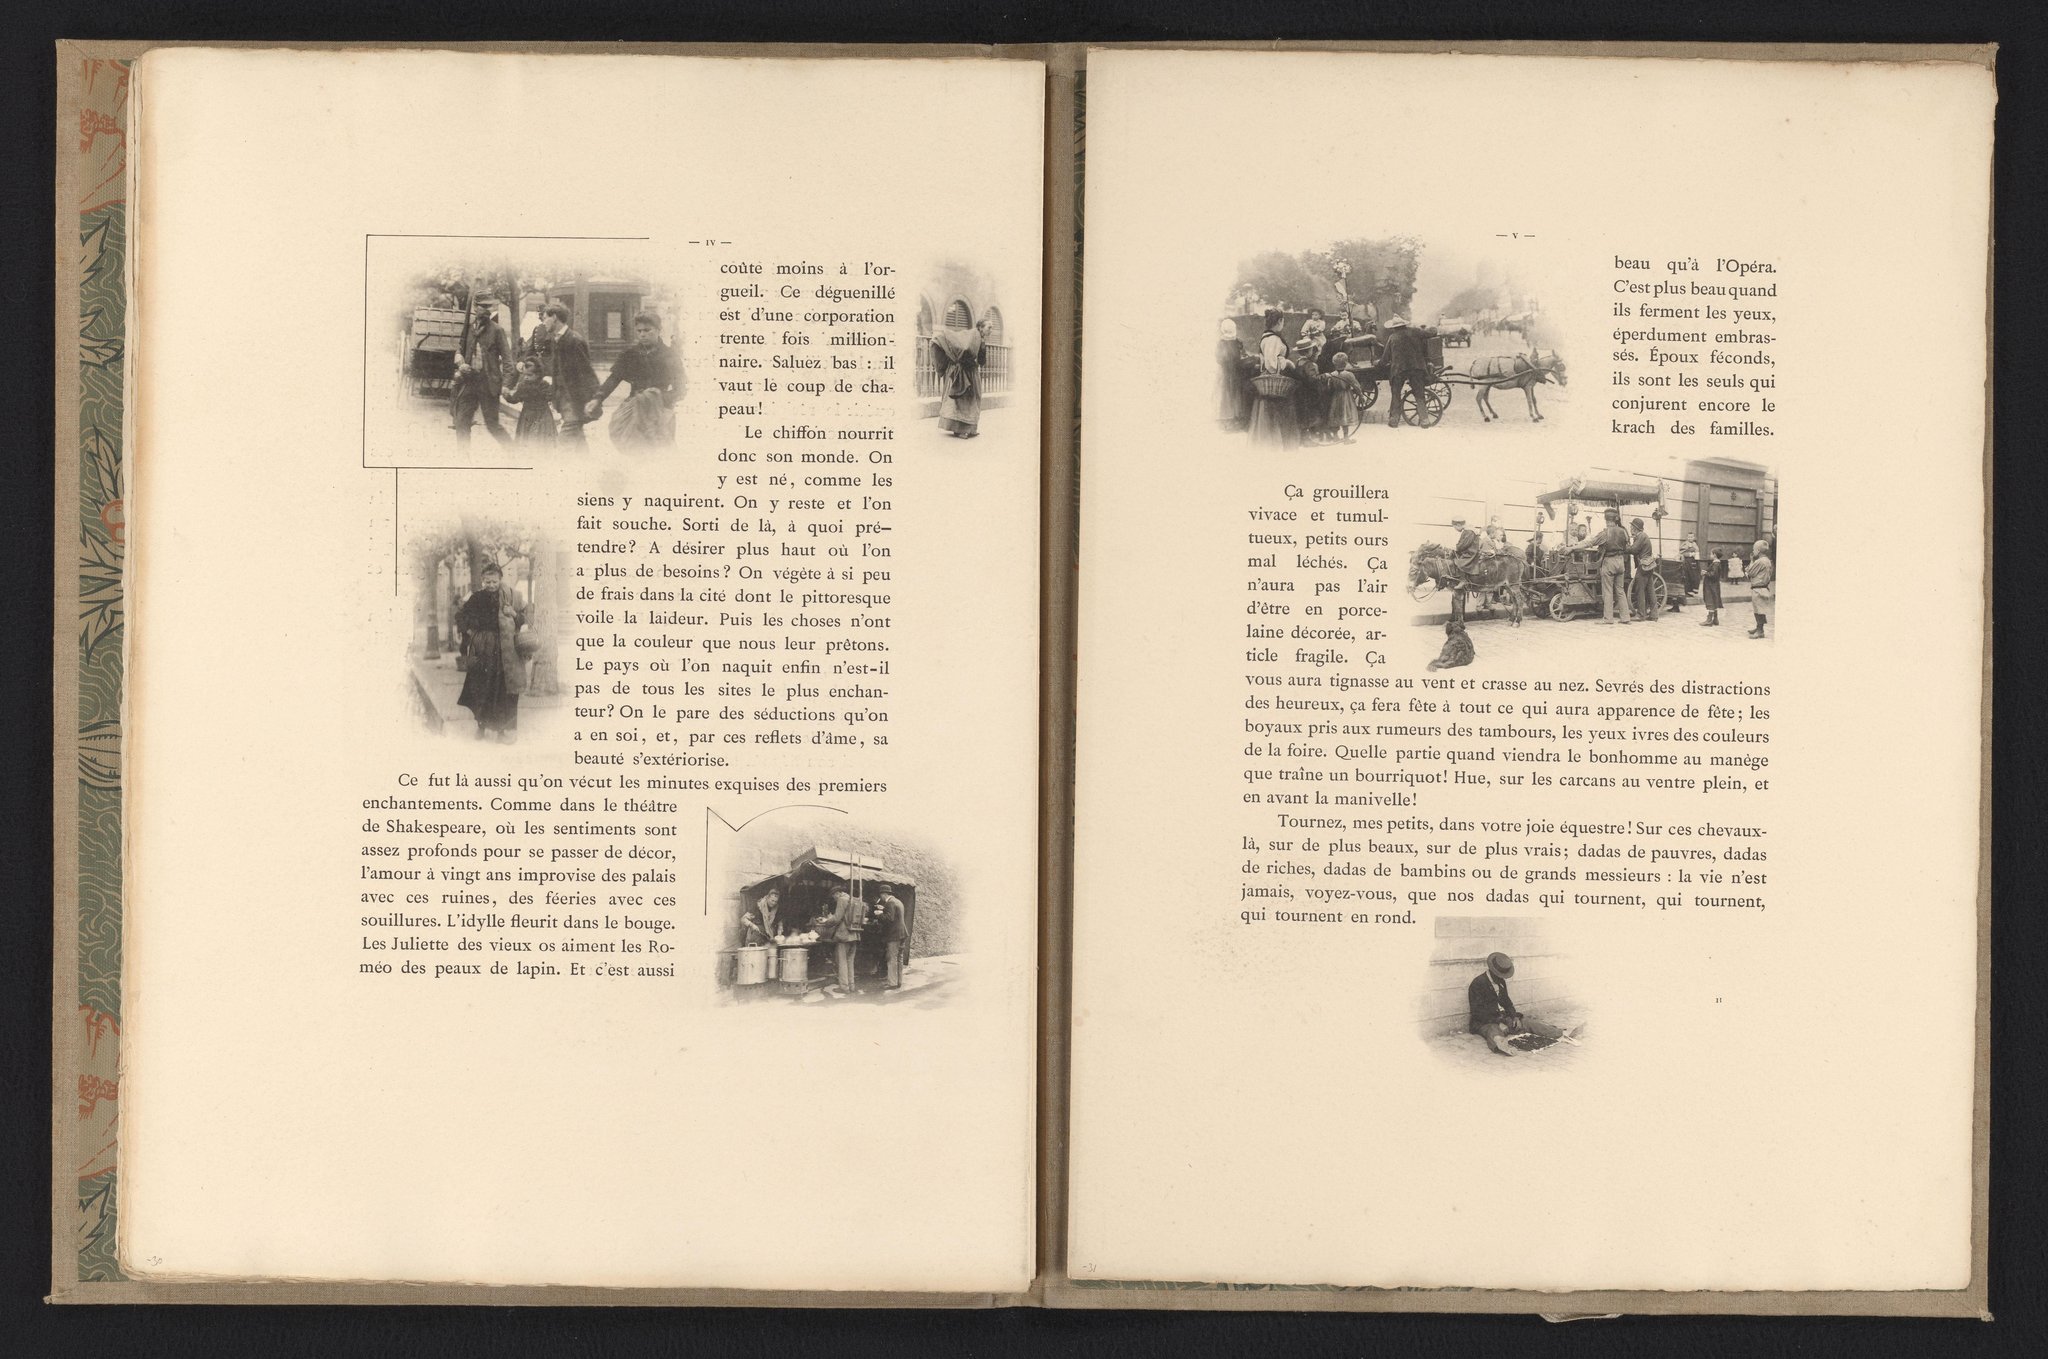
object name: album leaf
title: Drie taferelen met straatverkopers in Parijs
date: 1896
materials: paper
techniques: photograph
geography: paris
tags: street-trader, paris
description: Prenten op vijfenvijftigste ongenummerde pagina.